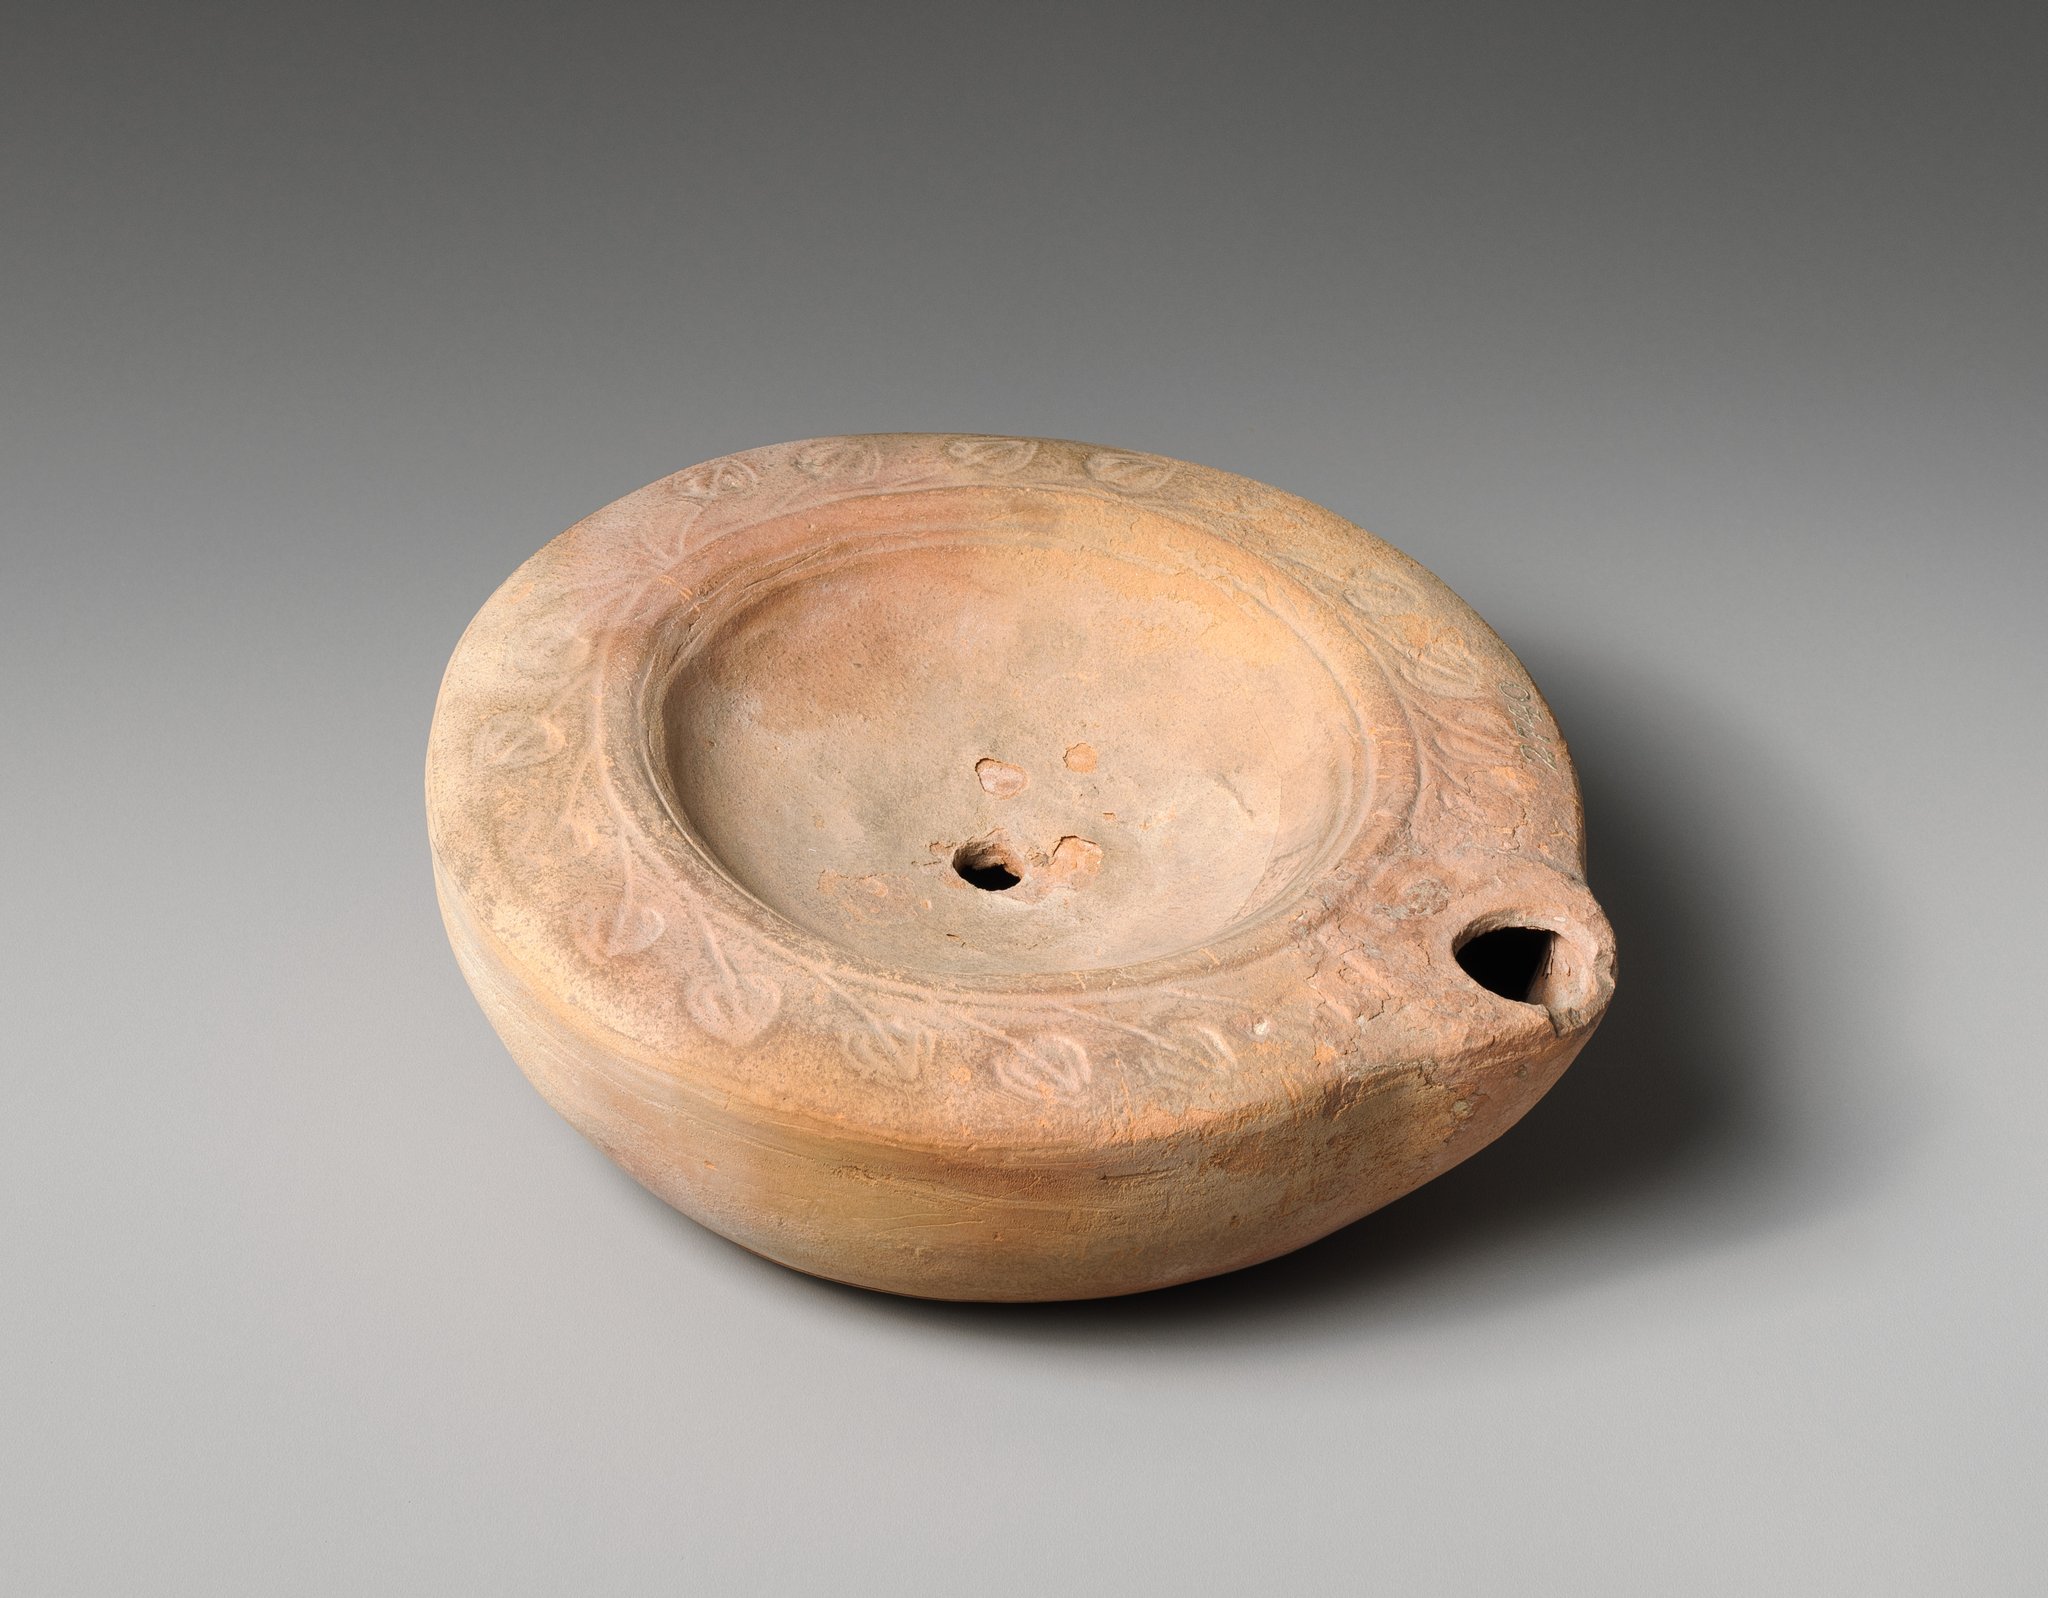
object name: lamp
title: Terracotta oil lamp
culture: roman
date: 101-200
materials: terracotta